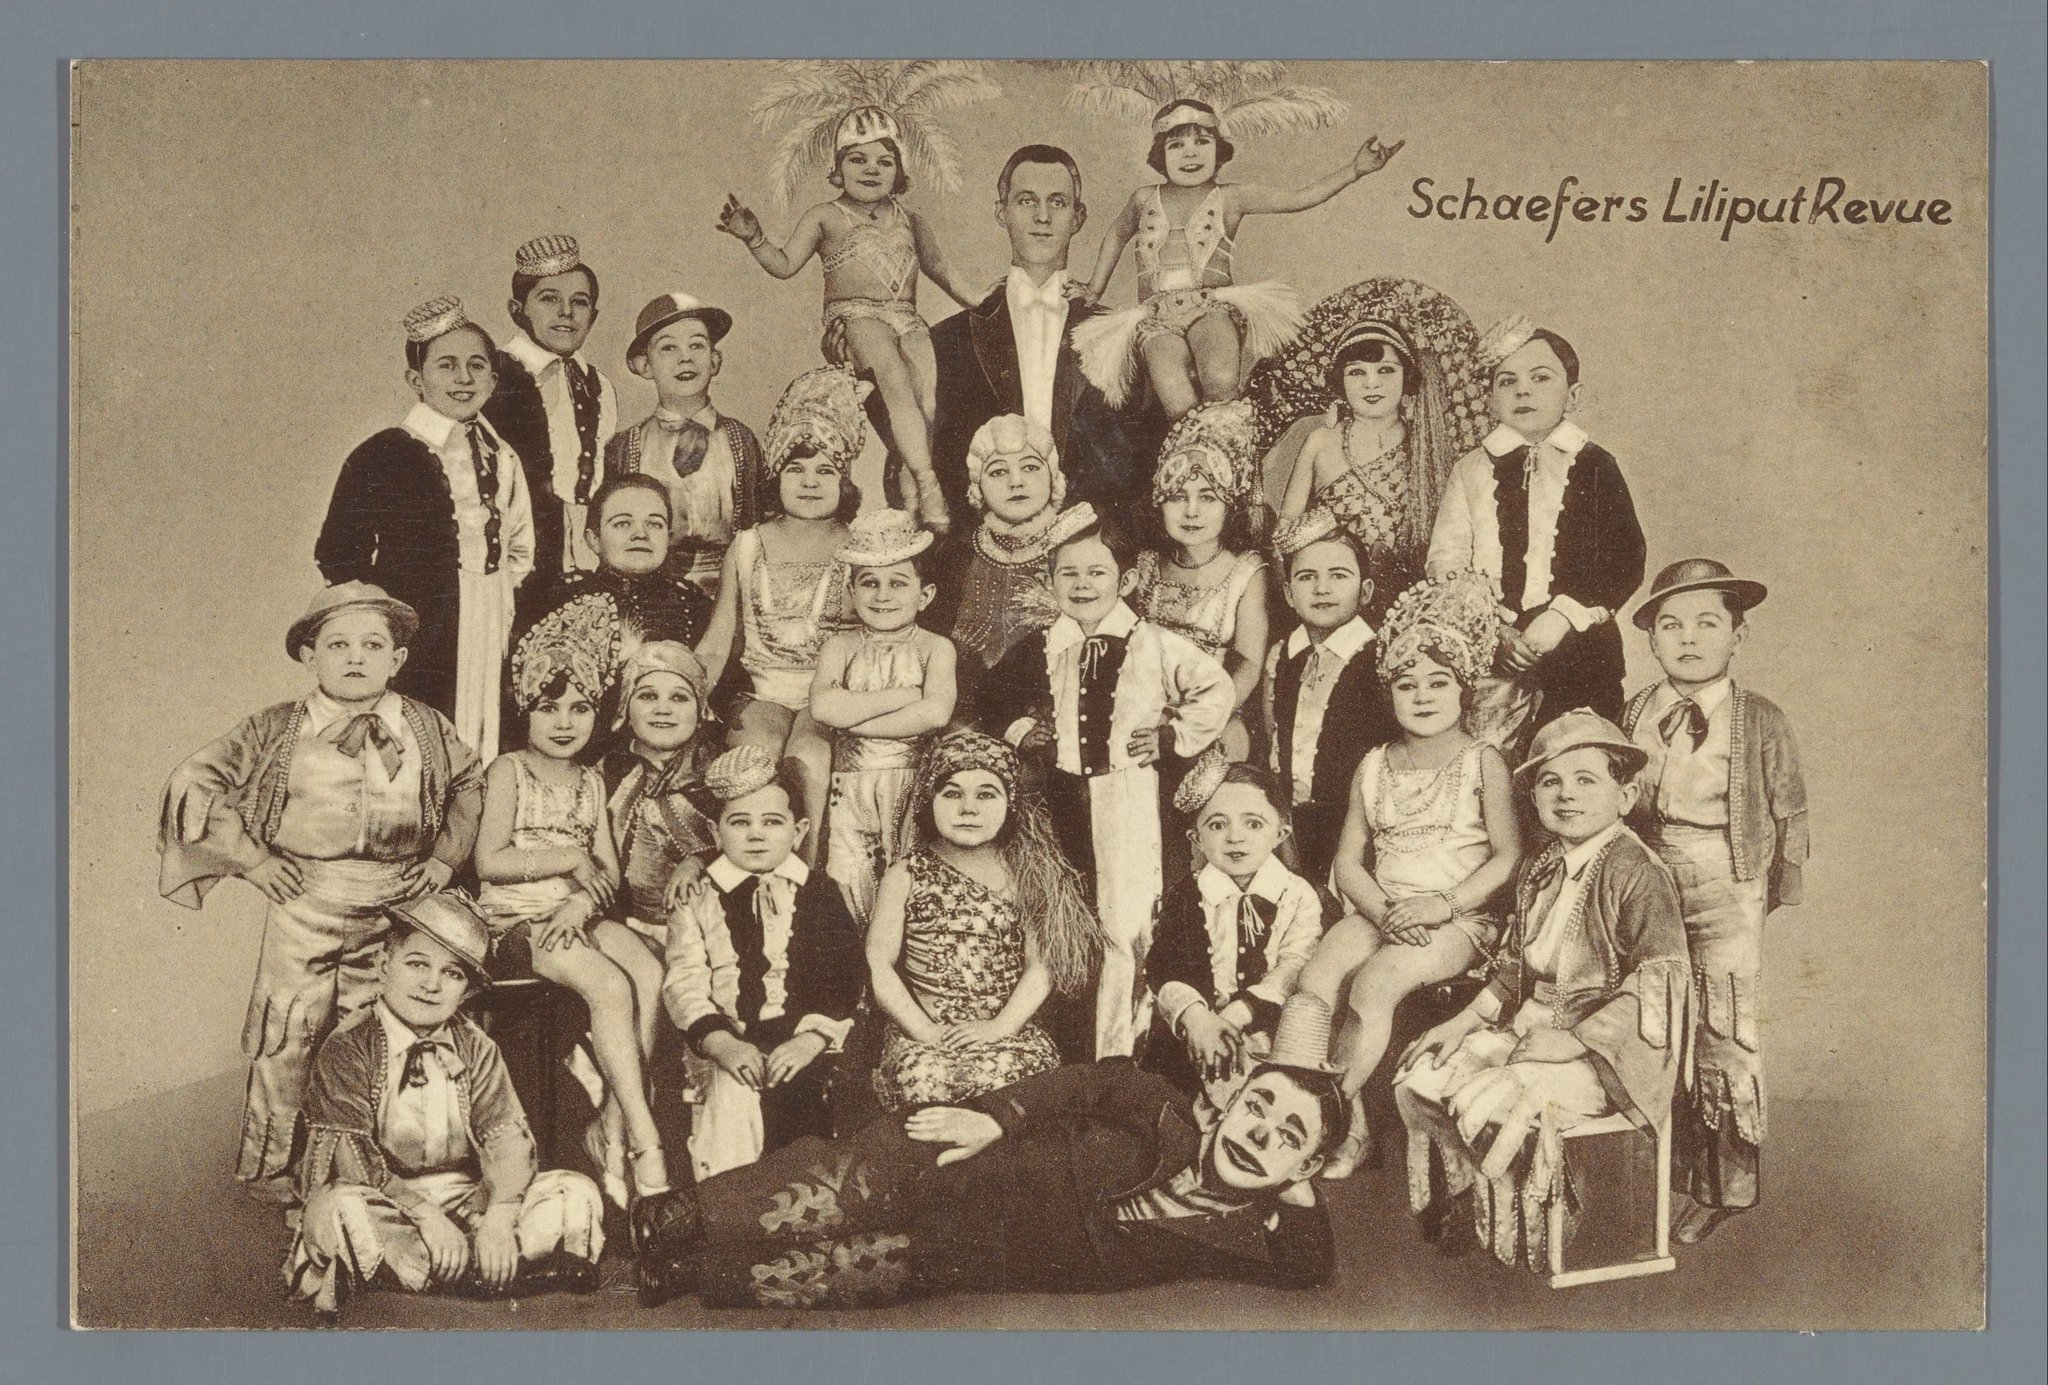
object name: photomechanical print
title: Groepsportret van medewerkers van Schaefer's Sprookjesstad Lilliput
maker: Anonymous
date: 1920-1940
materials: paper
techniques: photograph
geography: lübeck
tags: anonymous historical persons portrayed in a group, in a group-portrait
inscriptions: inscription: ‘Schaefers Liliput Revue’